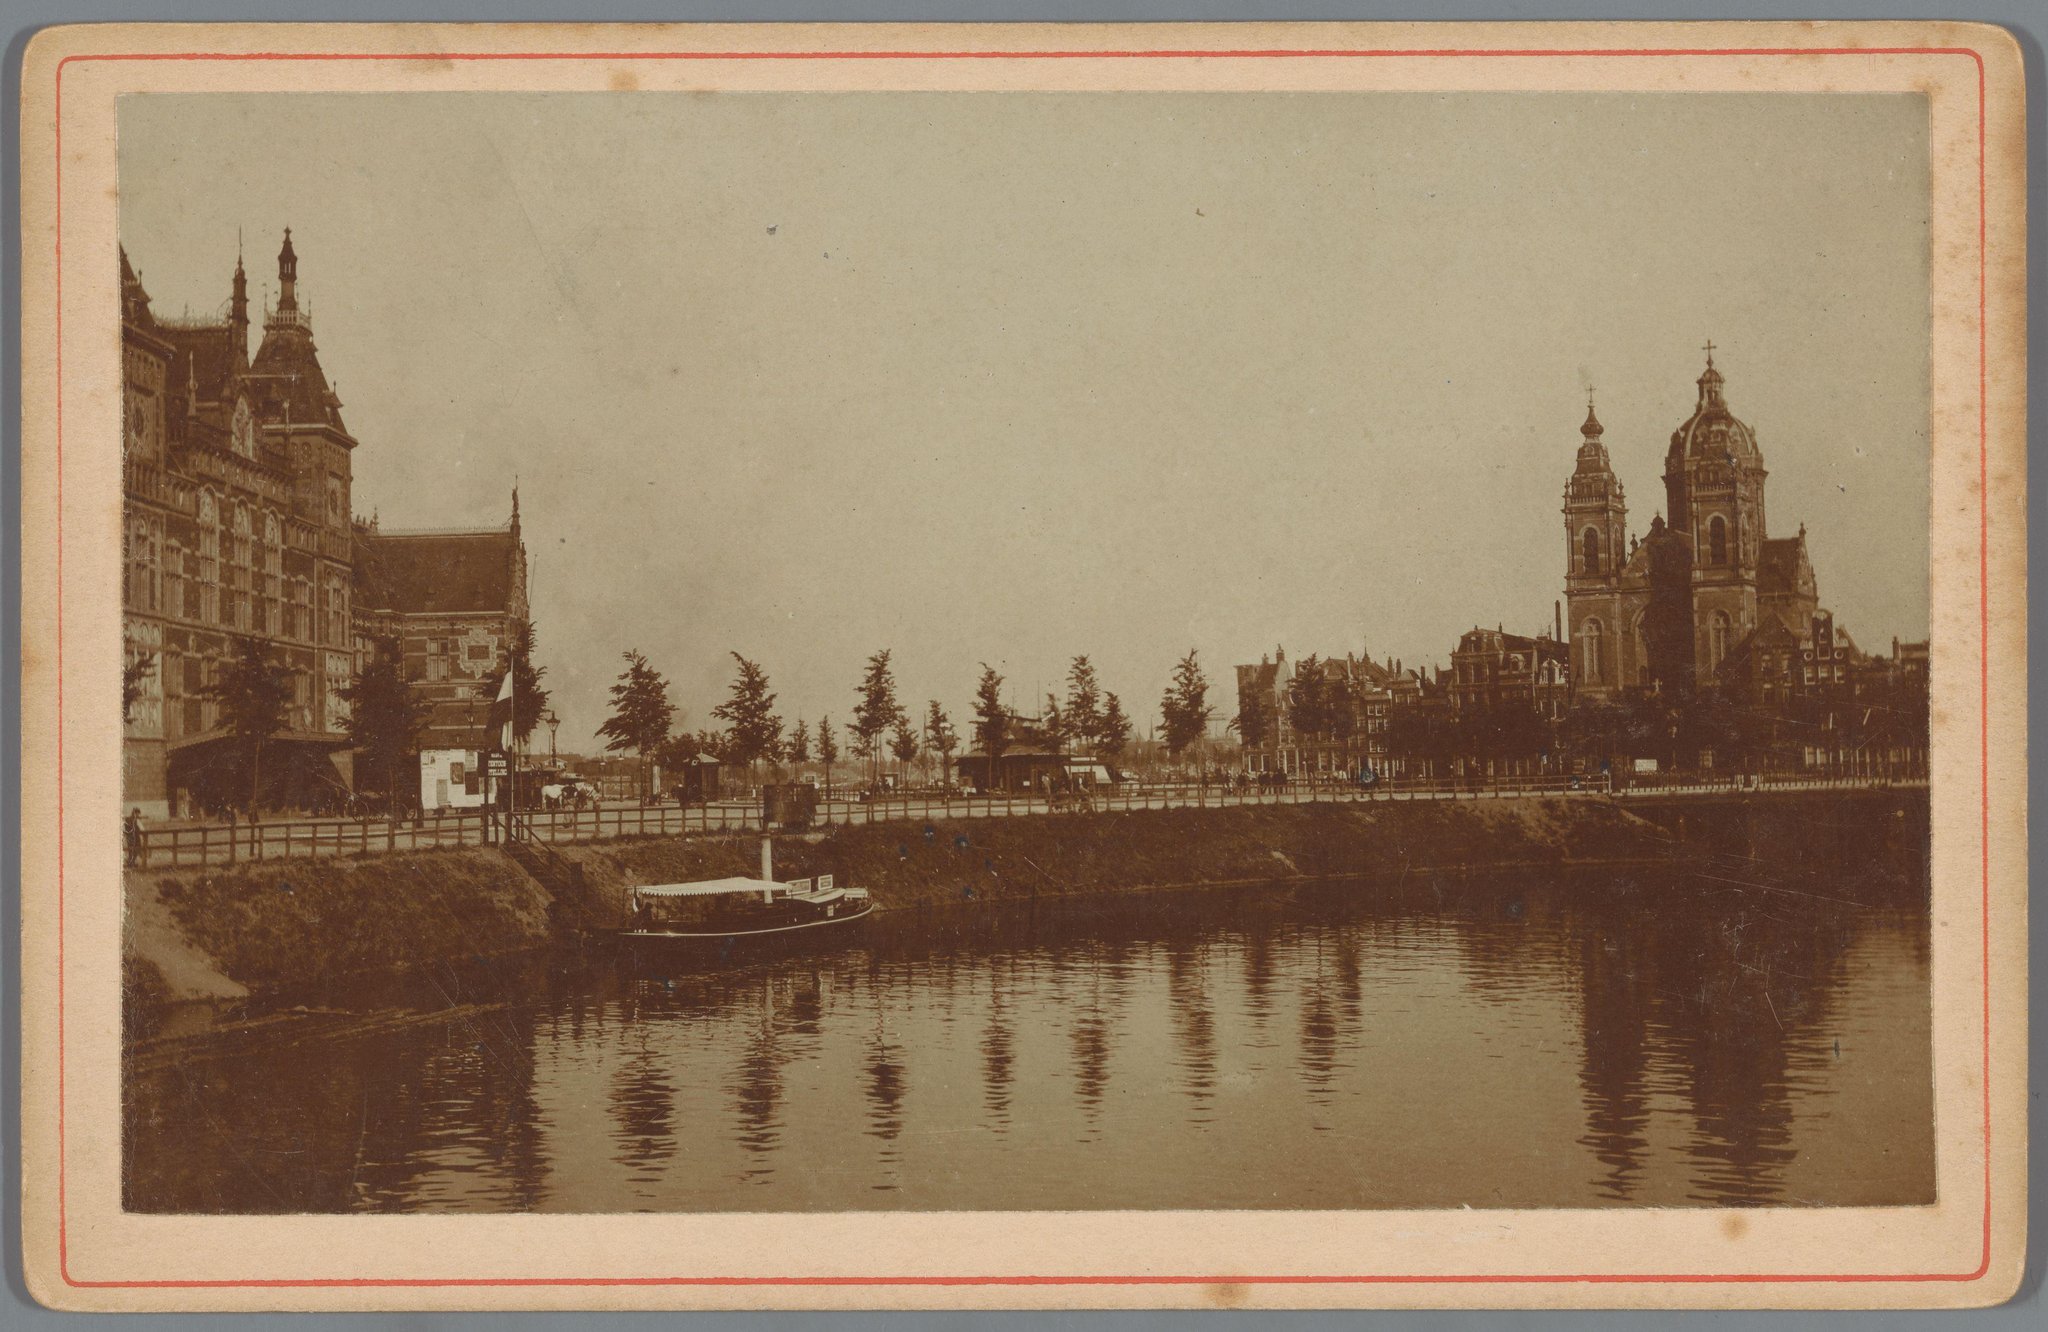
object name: cabinet photograph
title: Gezicht op Centraal Station en Nicolaaskerk in Amsterdam, vanaf het Stationseiland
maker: Anonymous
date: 1880-1900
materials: cardboard, photographic support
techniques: collodion silver print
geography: amsterdam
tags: church (exterior), canals, waters (in city), station; shelter (railway, tramway)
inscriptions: name: ‘Vosmaer’, inscription: ‘Het stations-Eiland ziende op het Centraal-Station en op de sint Nicolaaskerk.’